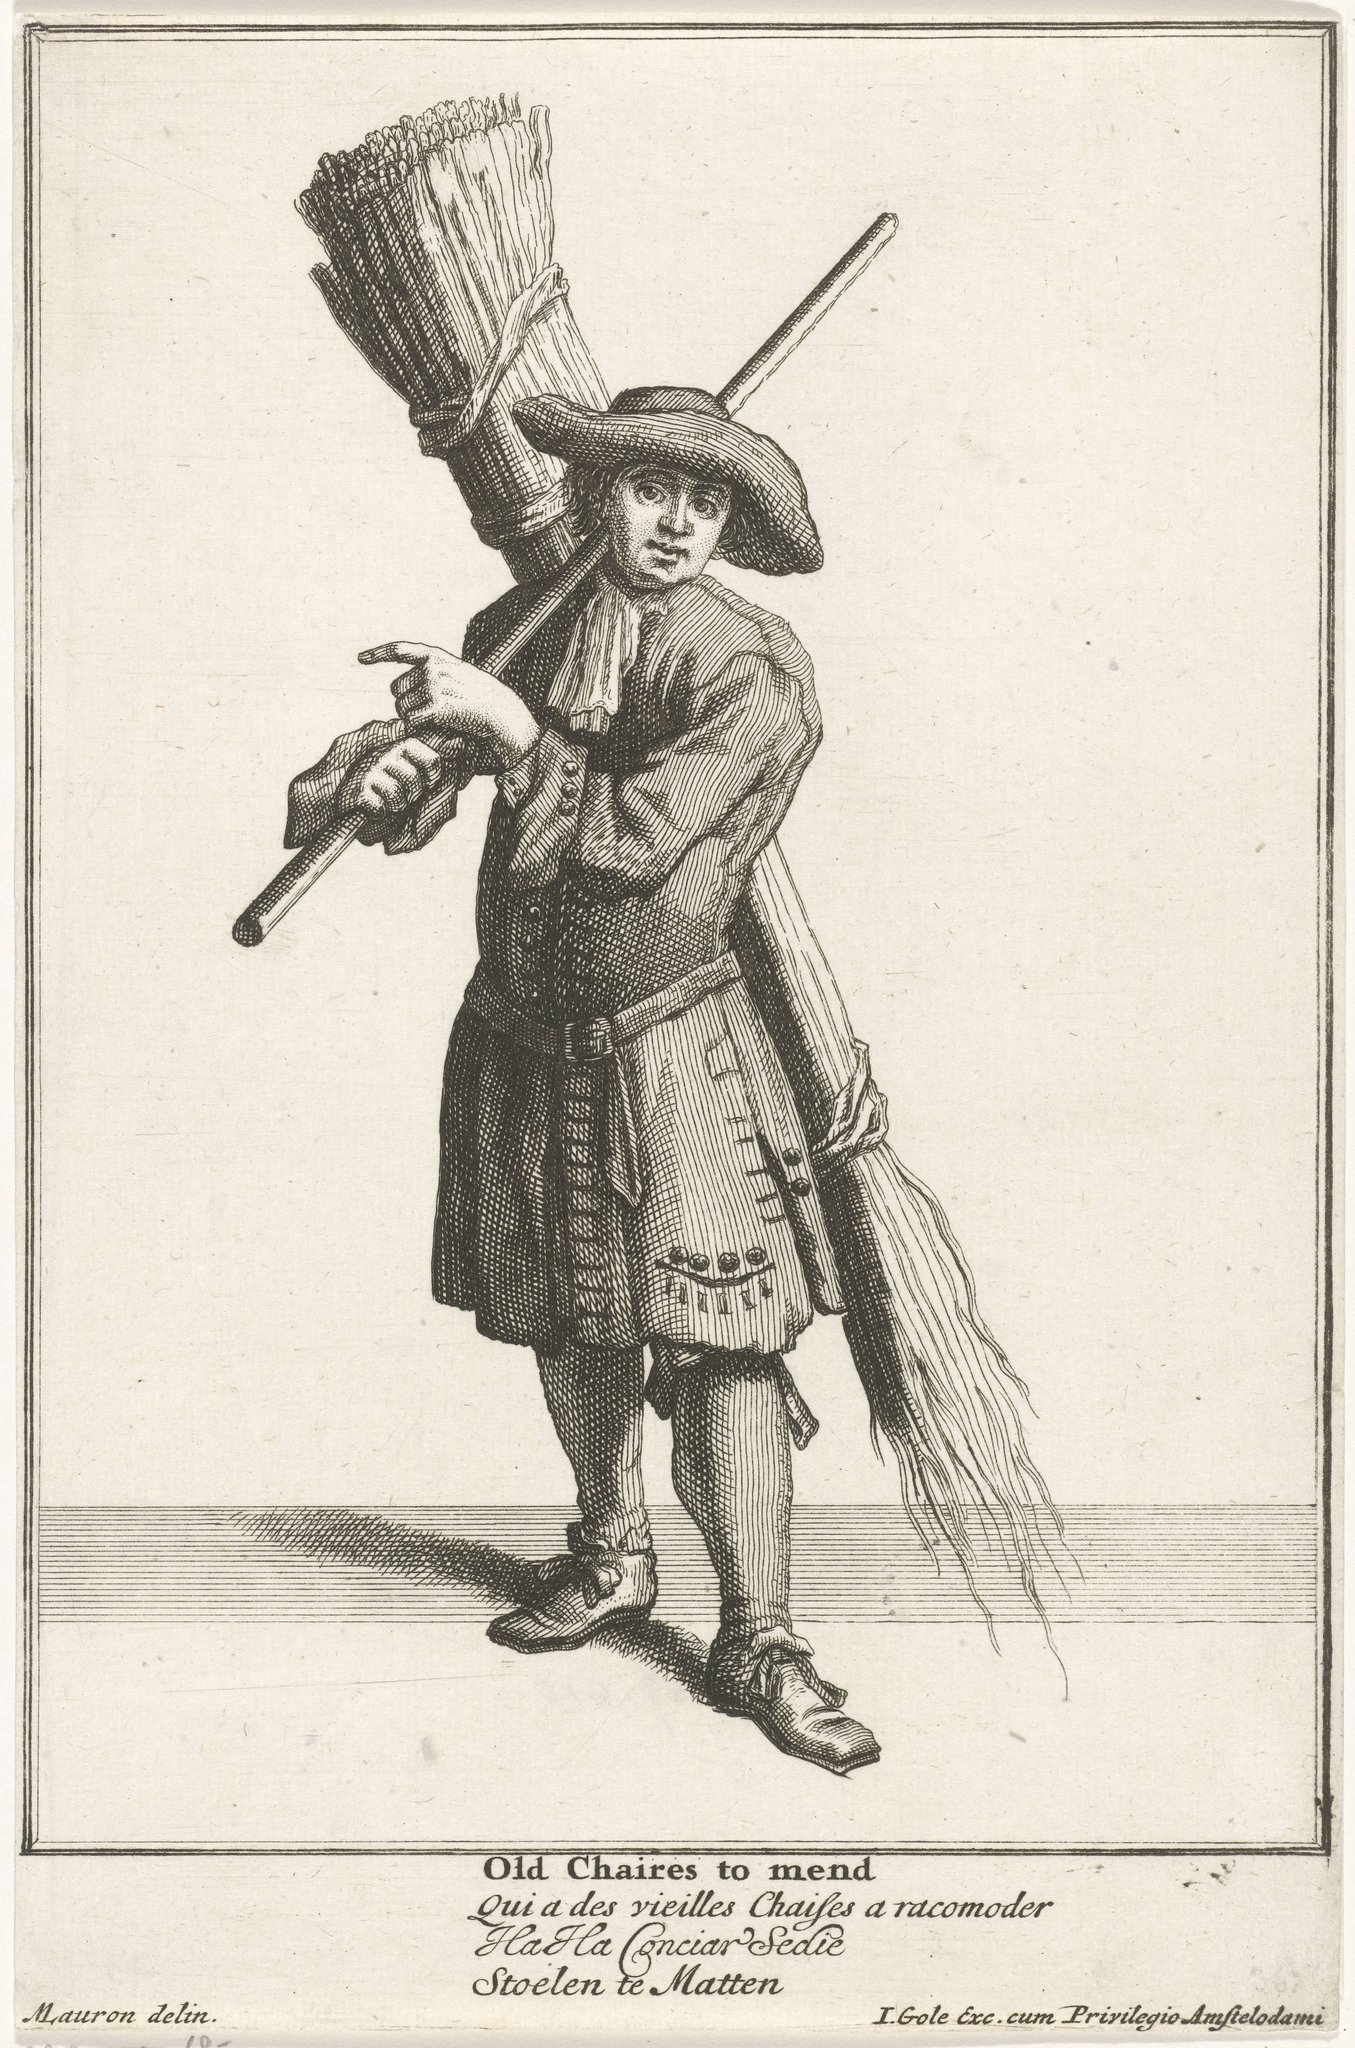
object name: print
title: The Cryes of the City of London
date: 1688-1724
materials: paper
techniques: engraving, etching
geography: london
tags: chair, reeds, rushes ~ building material, craftsman ~ applied arts, 'cris de paris', cries of london, etc.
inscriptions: collector's mark: Lugt 2228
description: Een mattenvlechter, die stoelen en matten herstelt. Op zijn rug een bundel biezen. De prent heeft een Engels, Frans, Italiaans en Nederlands onderschrift en maakt deel uit van een serie over de straatventers in Londen.